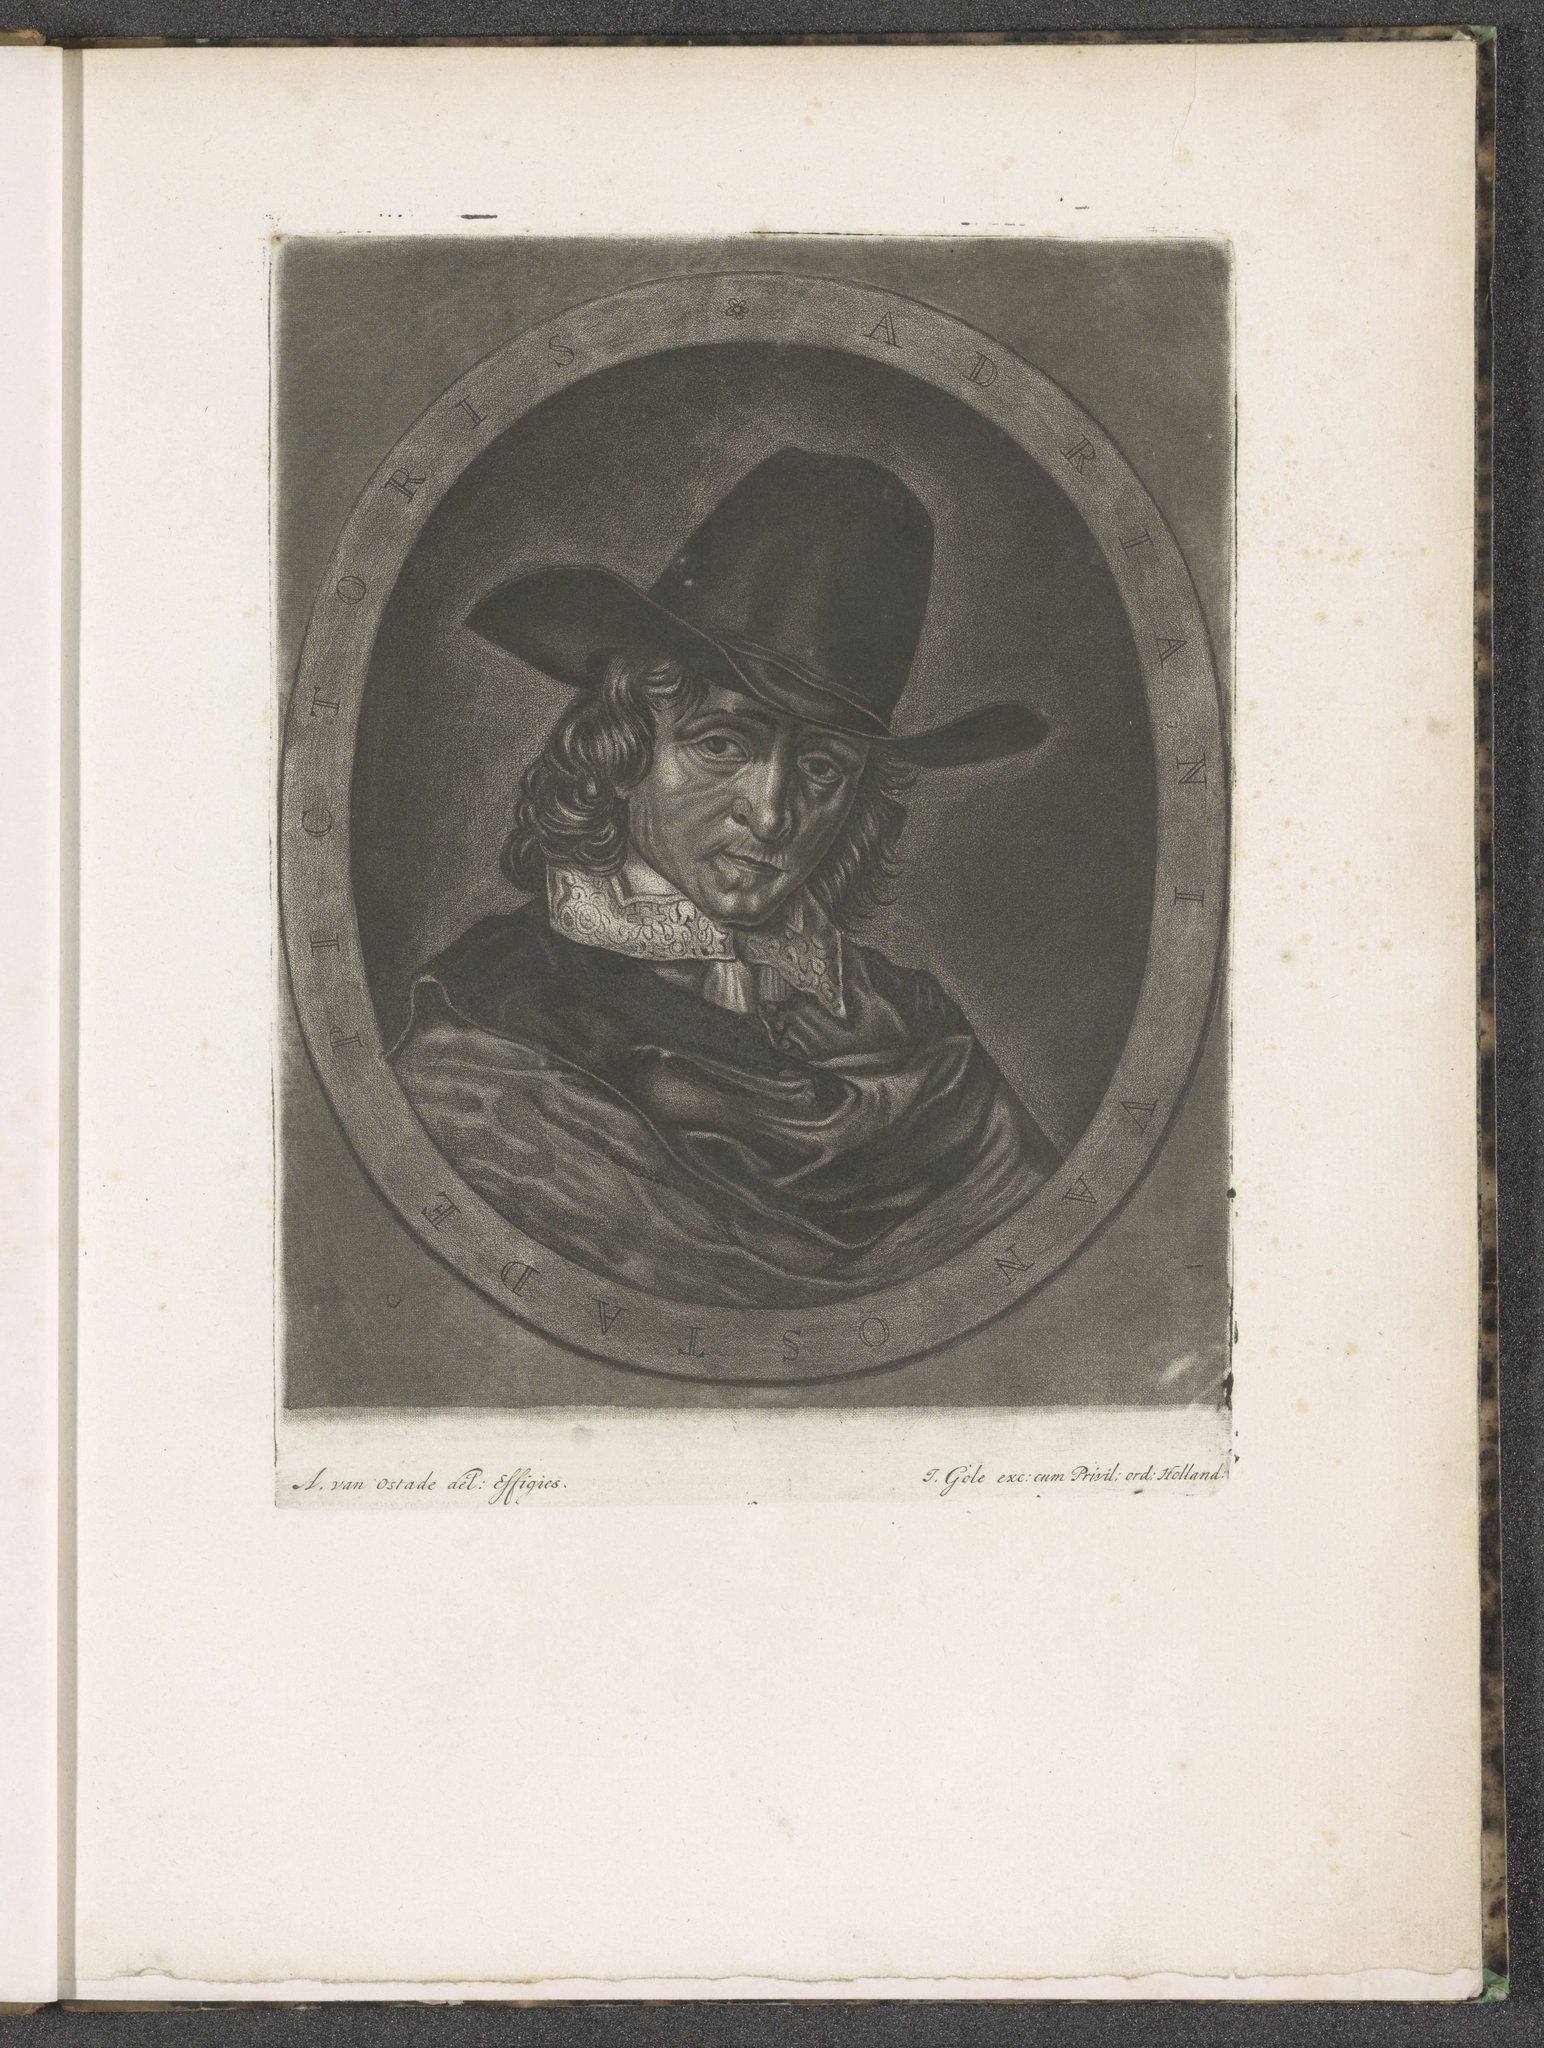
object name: album leaf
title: Portret van Adriaen van Ostade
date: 1670-1724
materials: paper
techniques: aquatint, etching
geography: haarlem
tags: haarlem, print maker, draughtsman, adriaen van ostade, portrait, self-portrait of artist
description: De schilder draagt een hoed. In een ovale omlijsting een randschrift met de naam en het beroep van de geportretteerde. Deze prent maakt deel uit van een album.